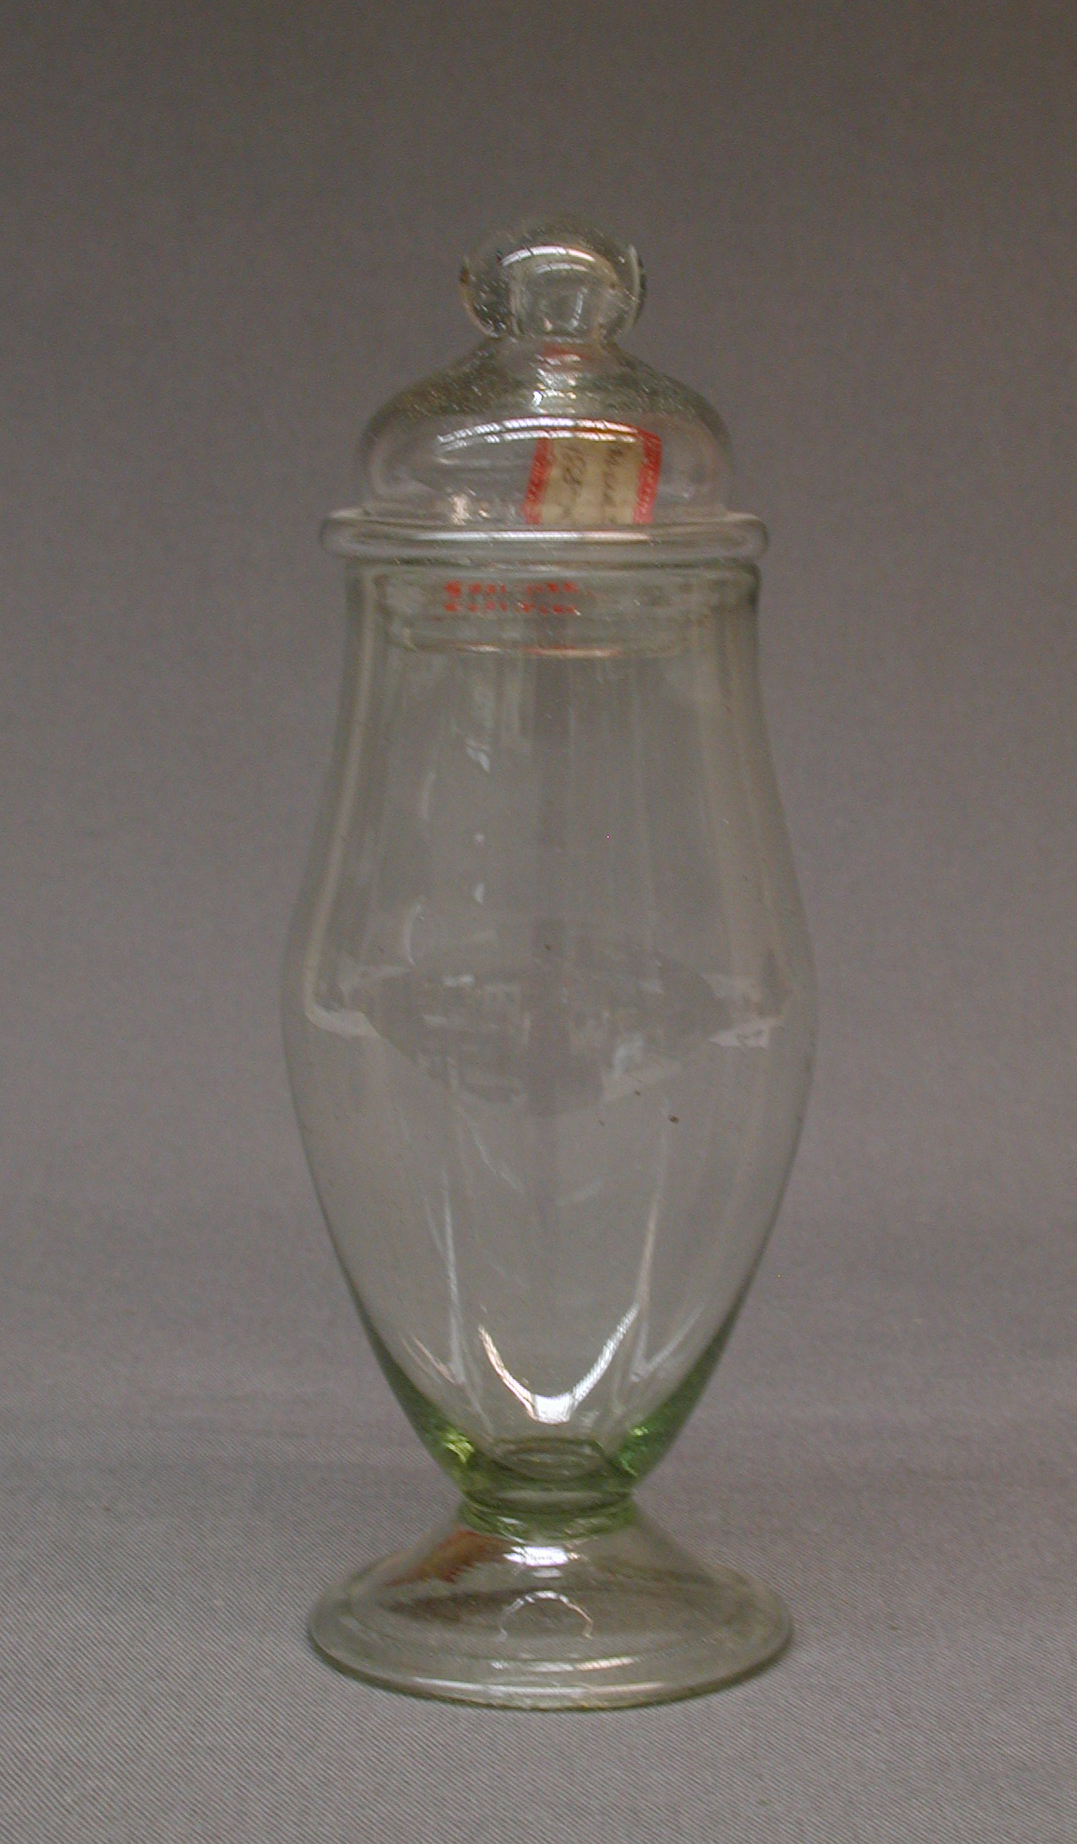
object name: vase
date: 1701-1800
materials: glass